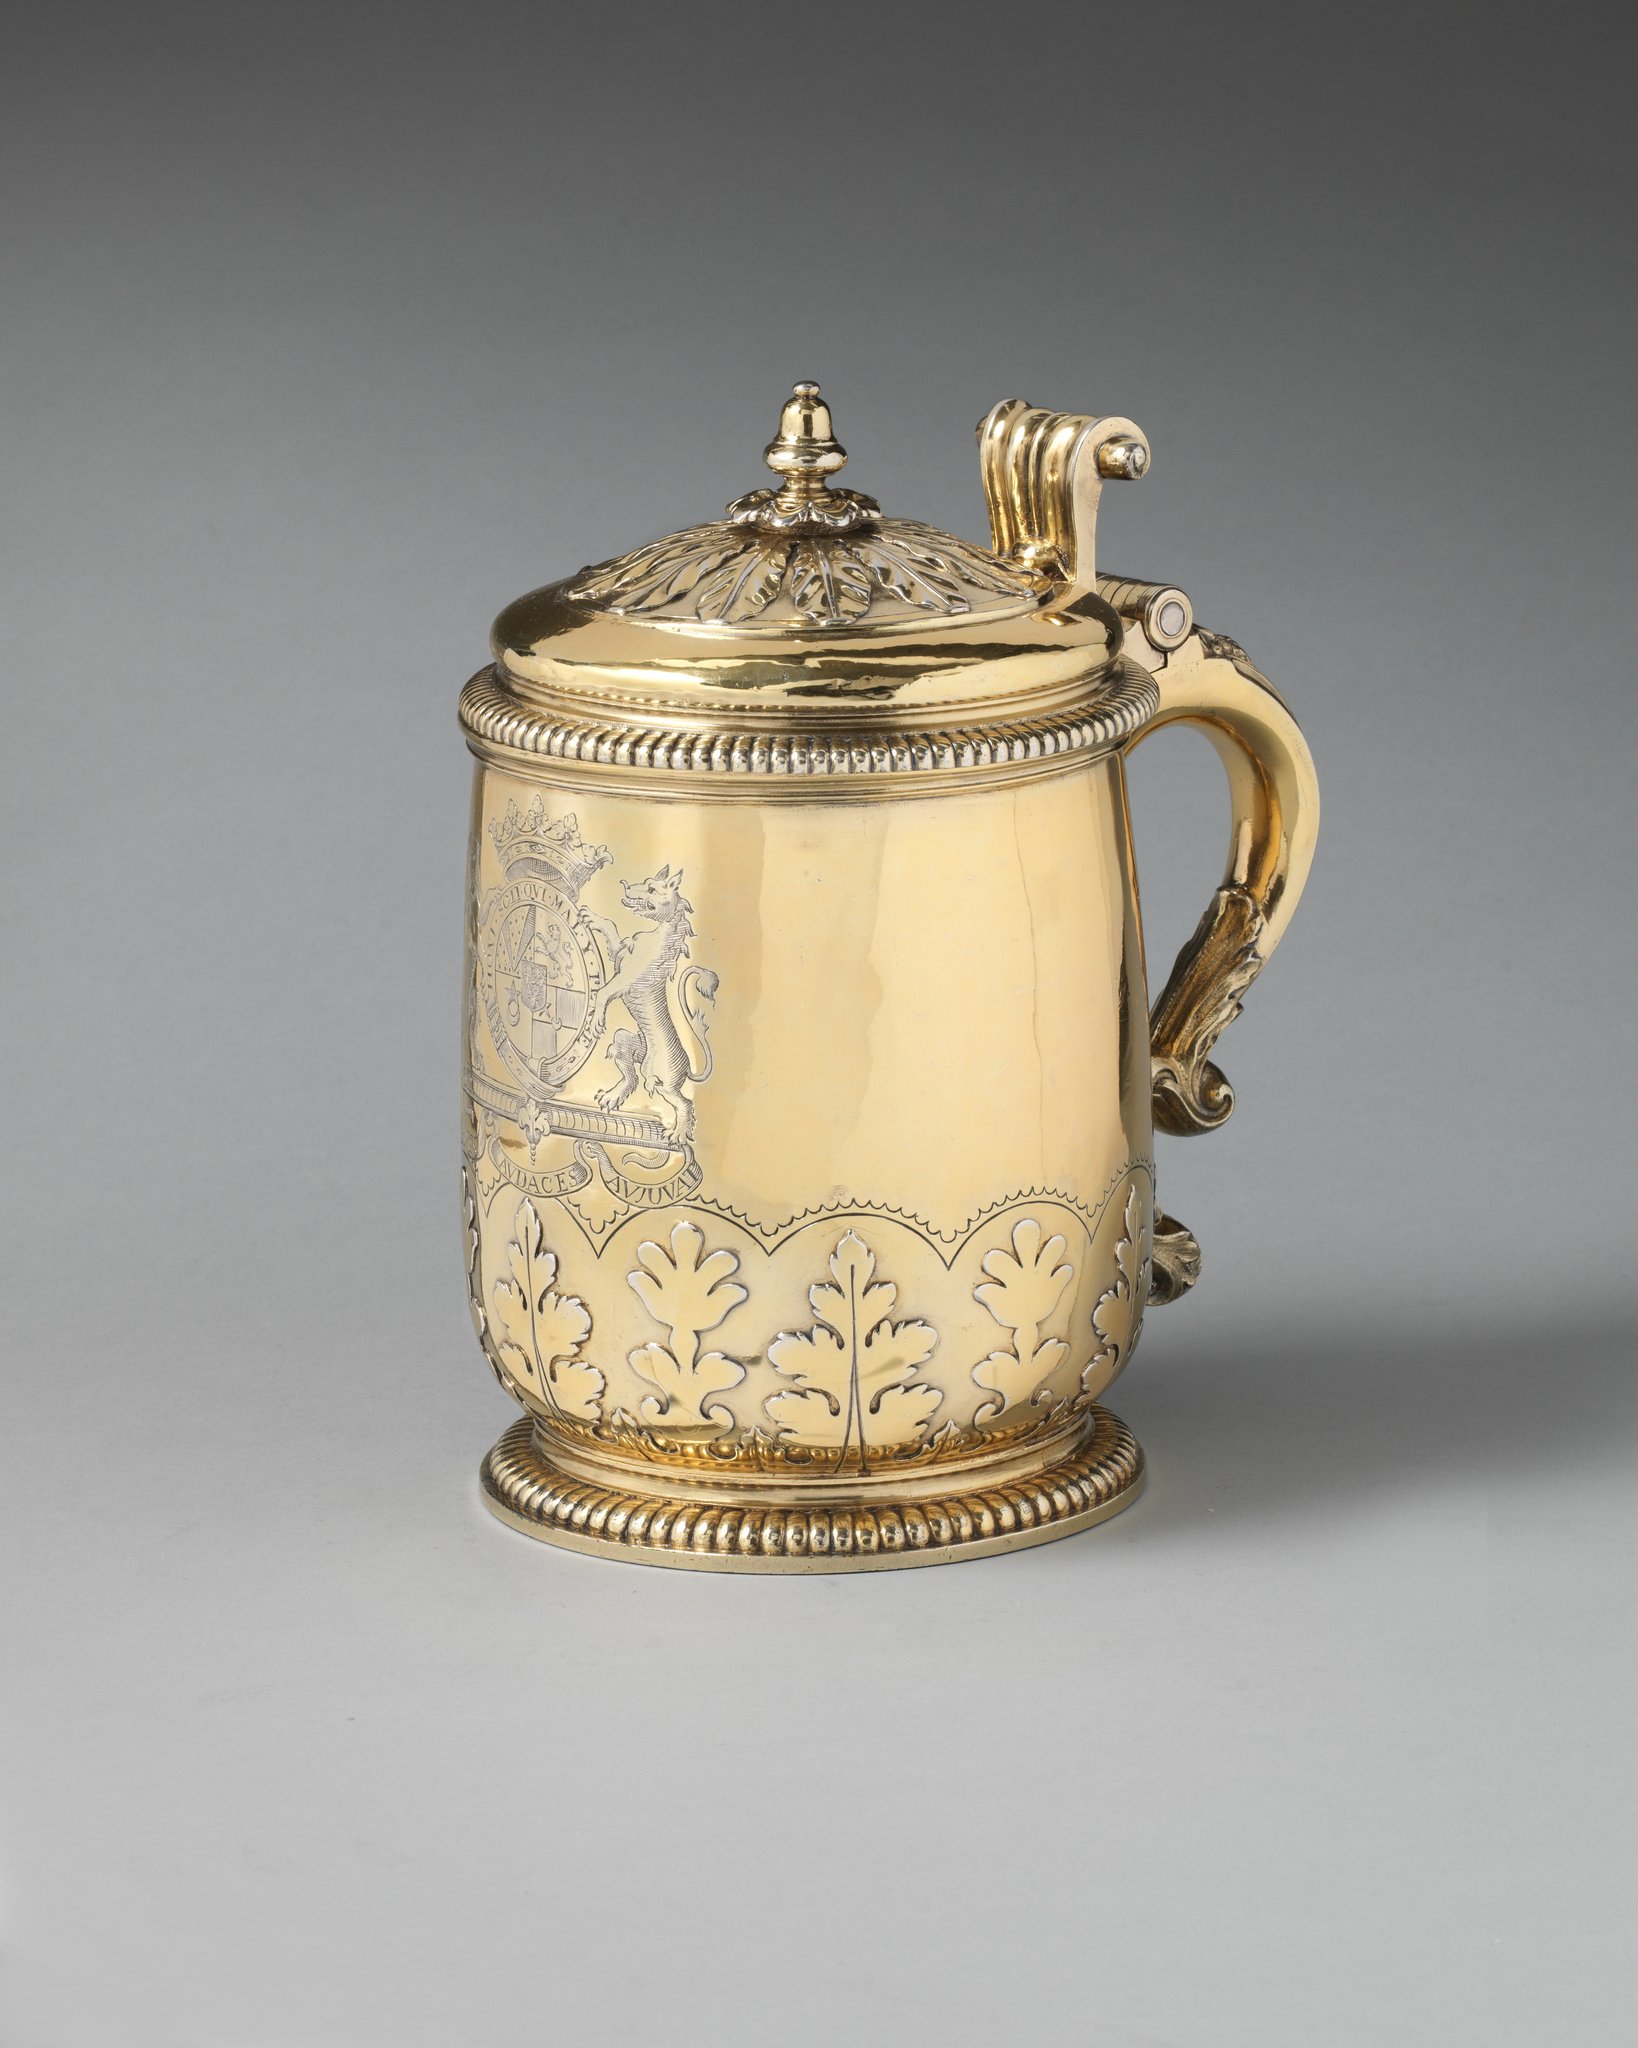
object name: tankard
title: Tankard (one of a pair)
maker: john le chartier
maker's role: maker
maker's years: 1698-1731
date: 1699-1700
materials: silver gilt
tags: coat of arms